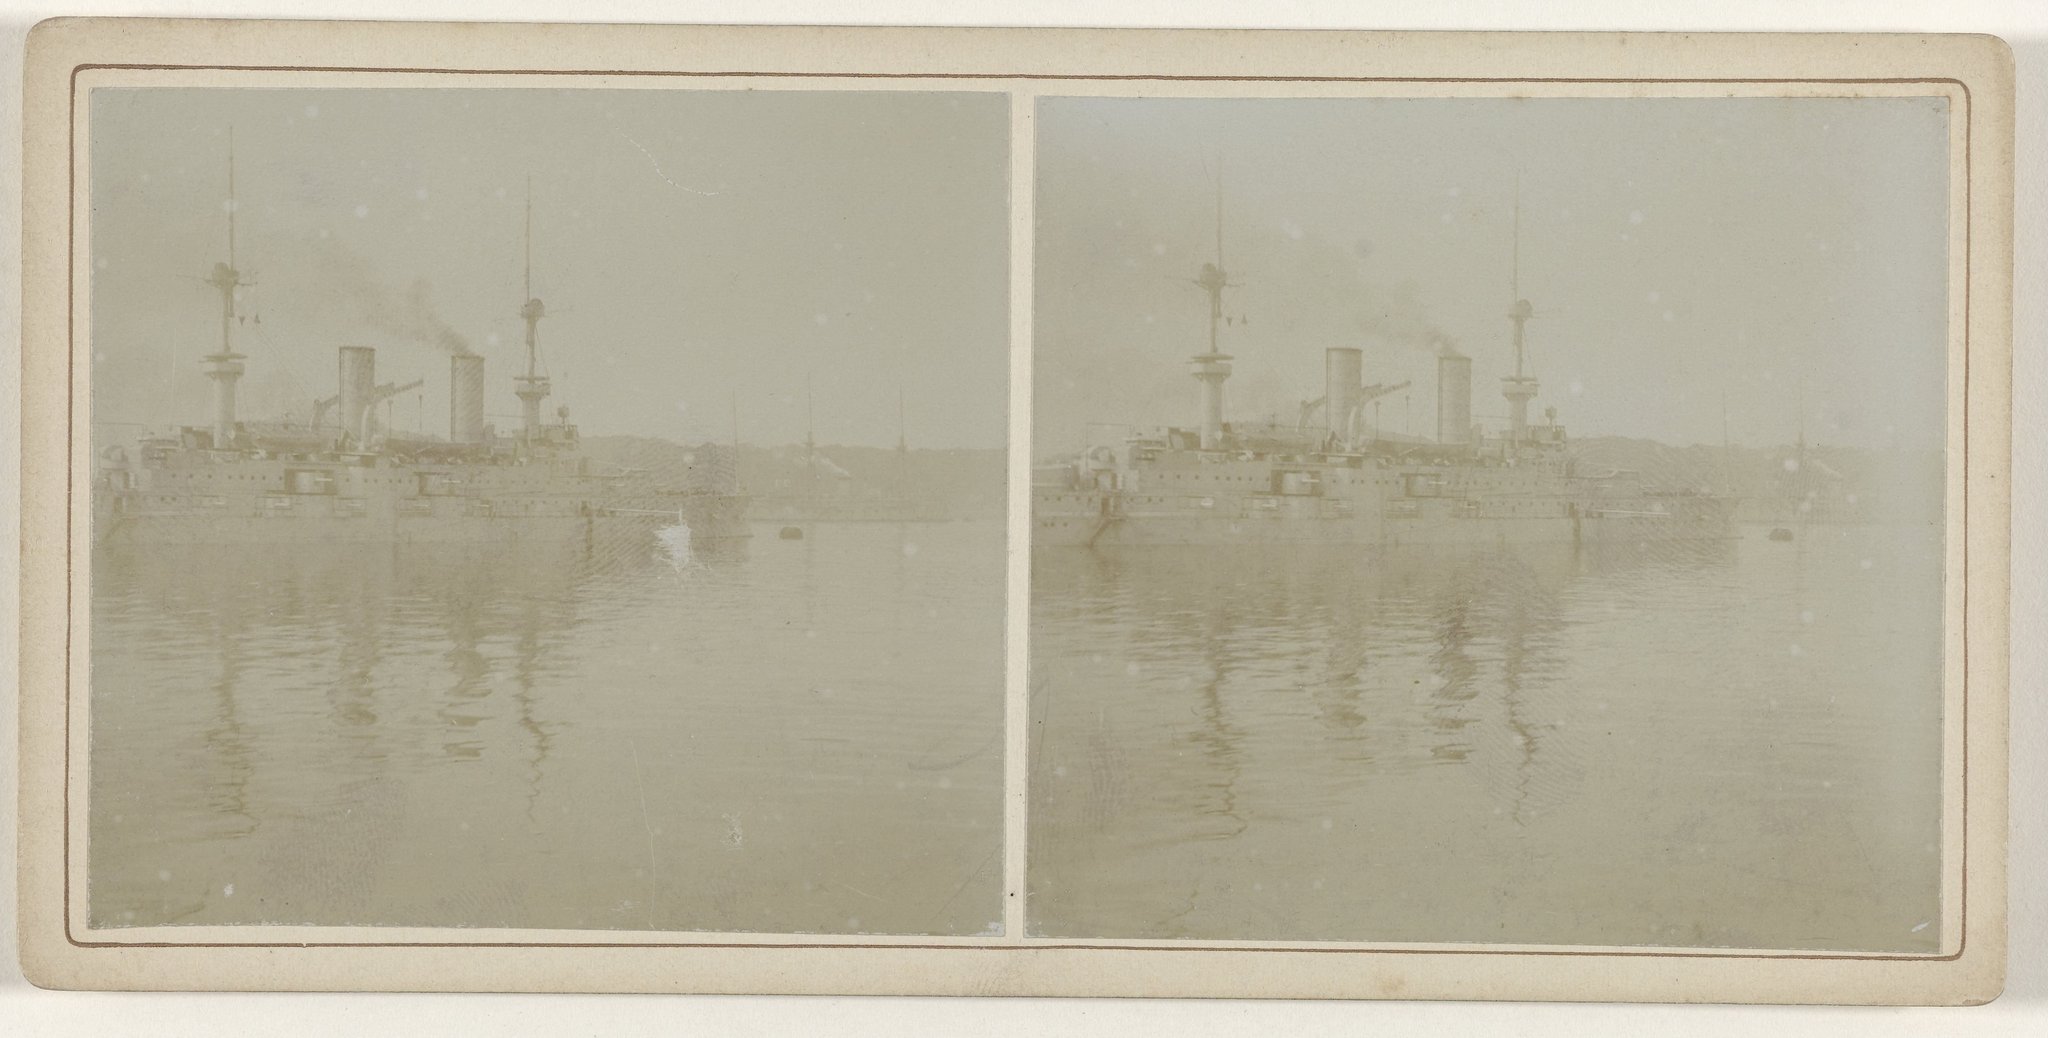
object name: stereograph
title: In de haven van Kiel. Een der oorlogsschepen welk we bezochten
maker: geldolph adriaan kessler (dolph)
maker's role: fotograaf, industrieel, voetballer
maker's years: 1884-1945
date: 1903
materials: paper, photographic support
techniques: collodion silver print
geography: germany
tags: kiel